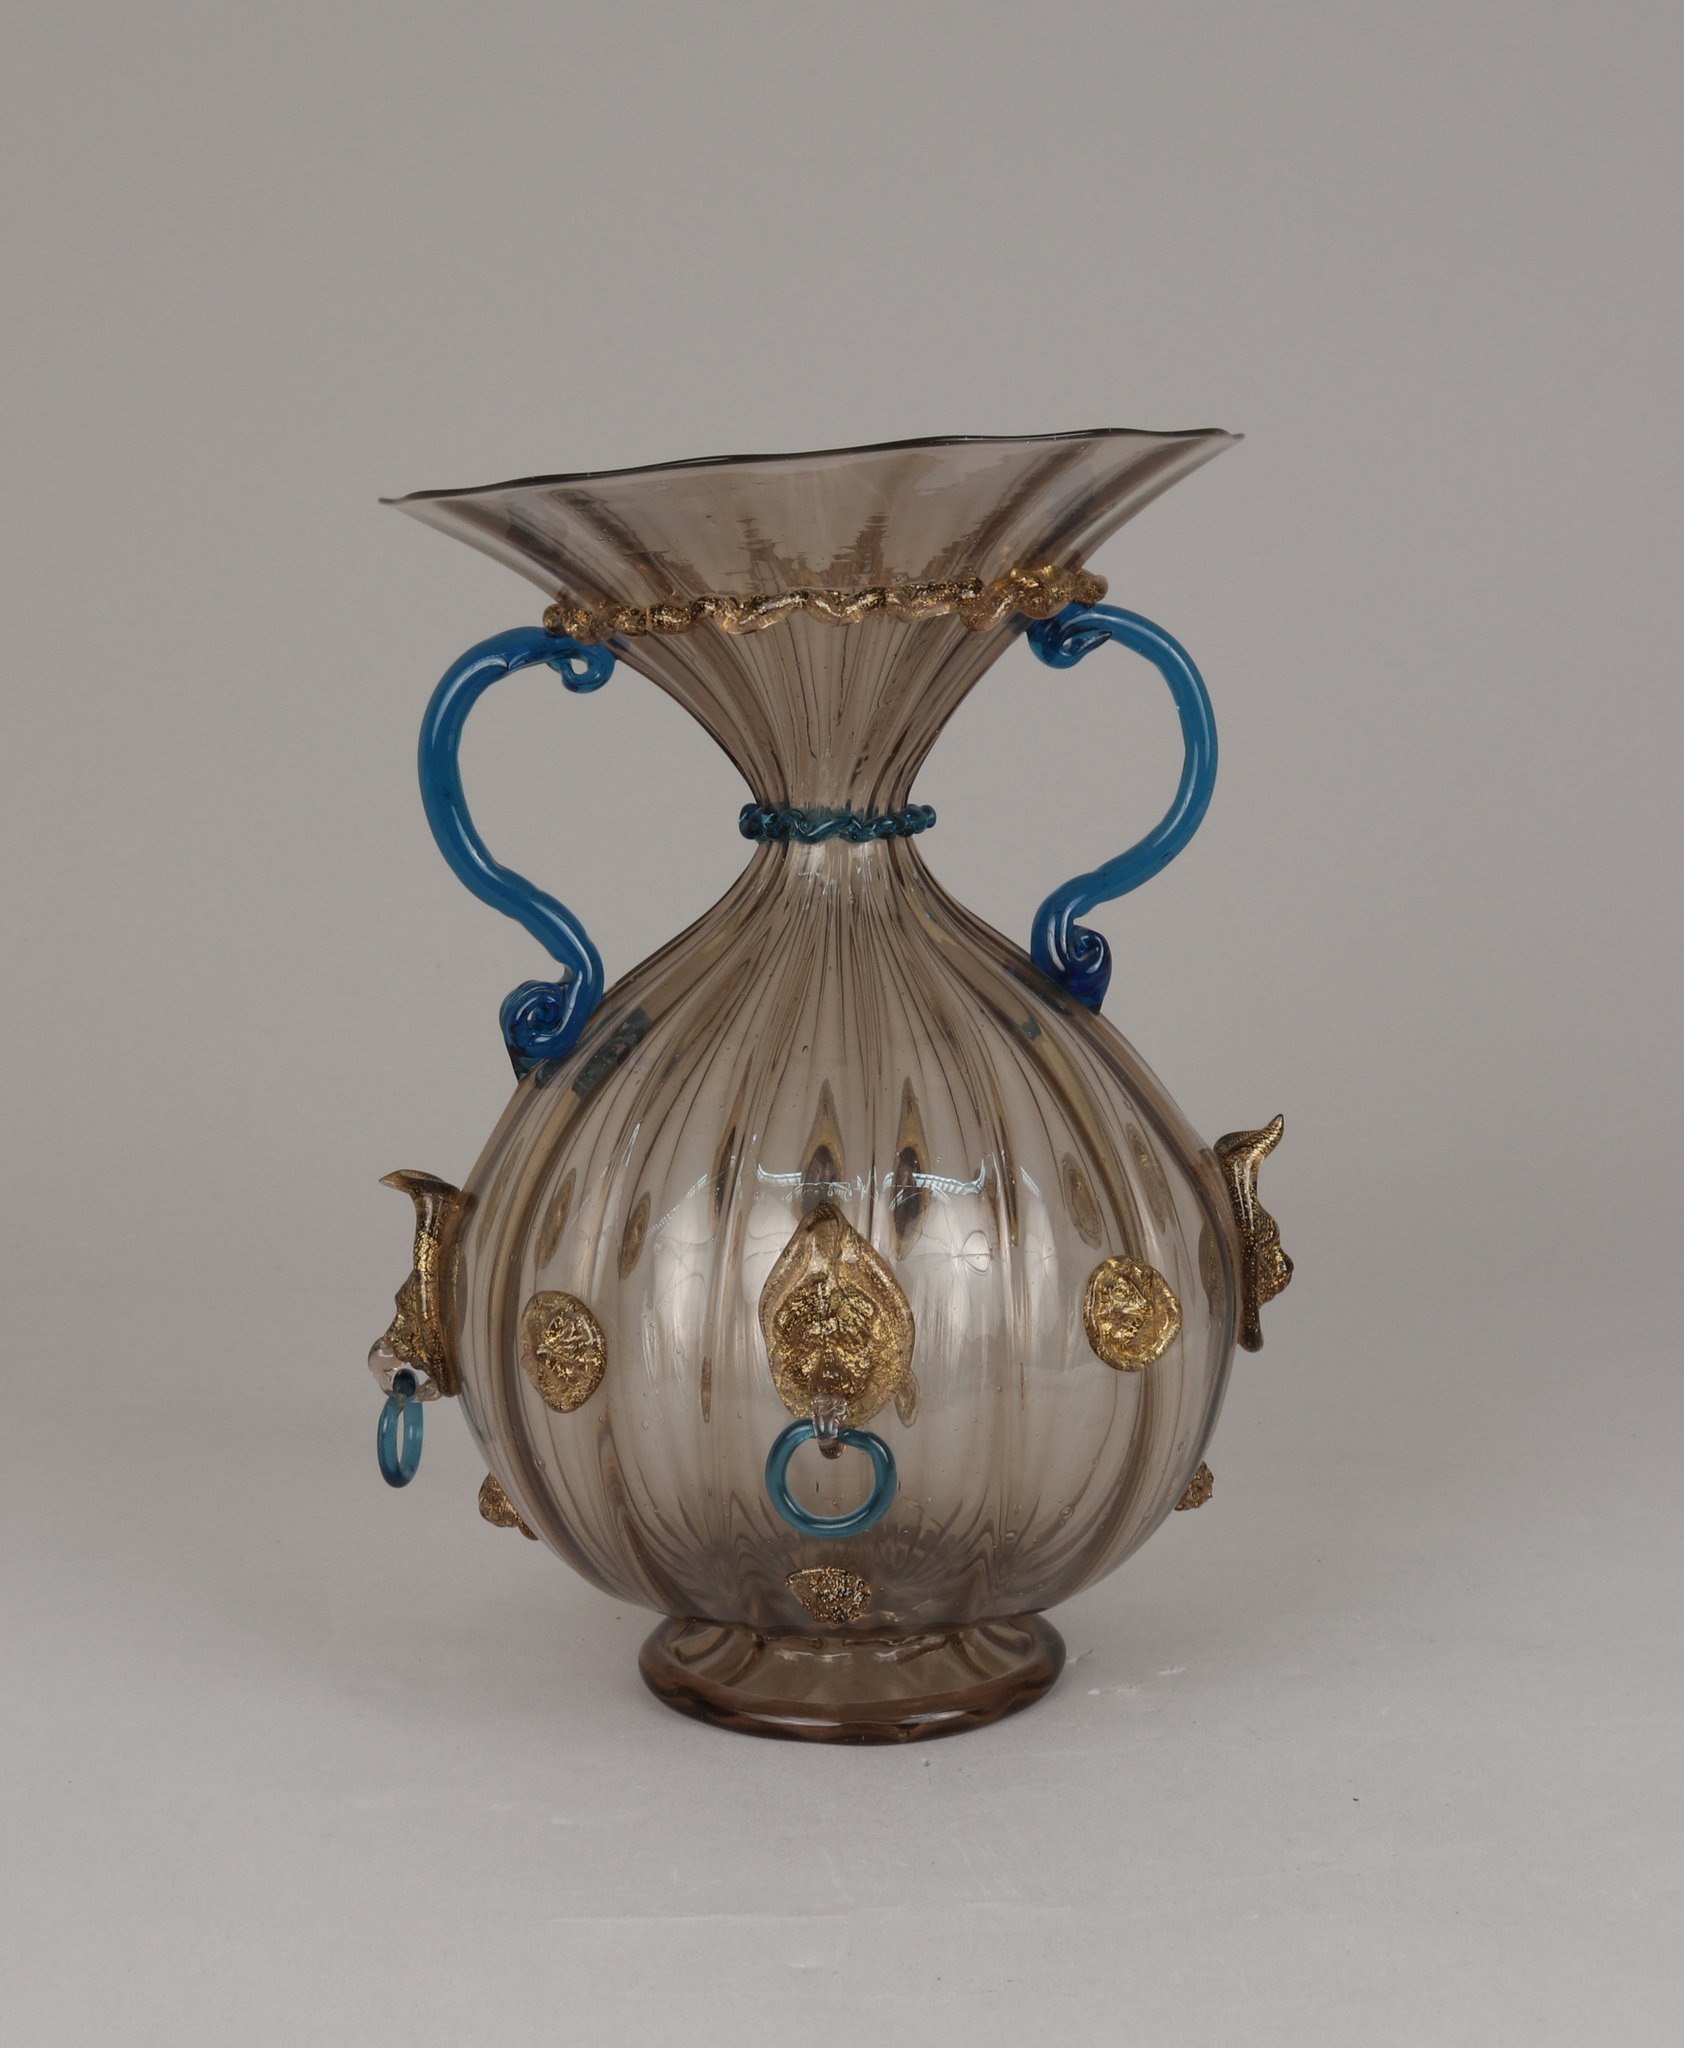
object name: vase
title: Ribbed and fluted vase with lion masks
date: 1801-1900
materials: glass